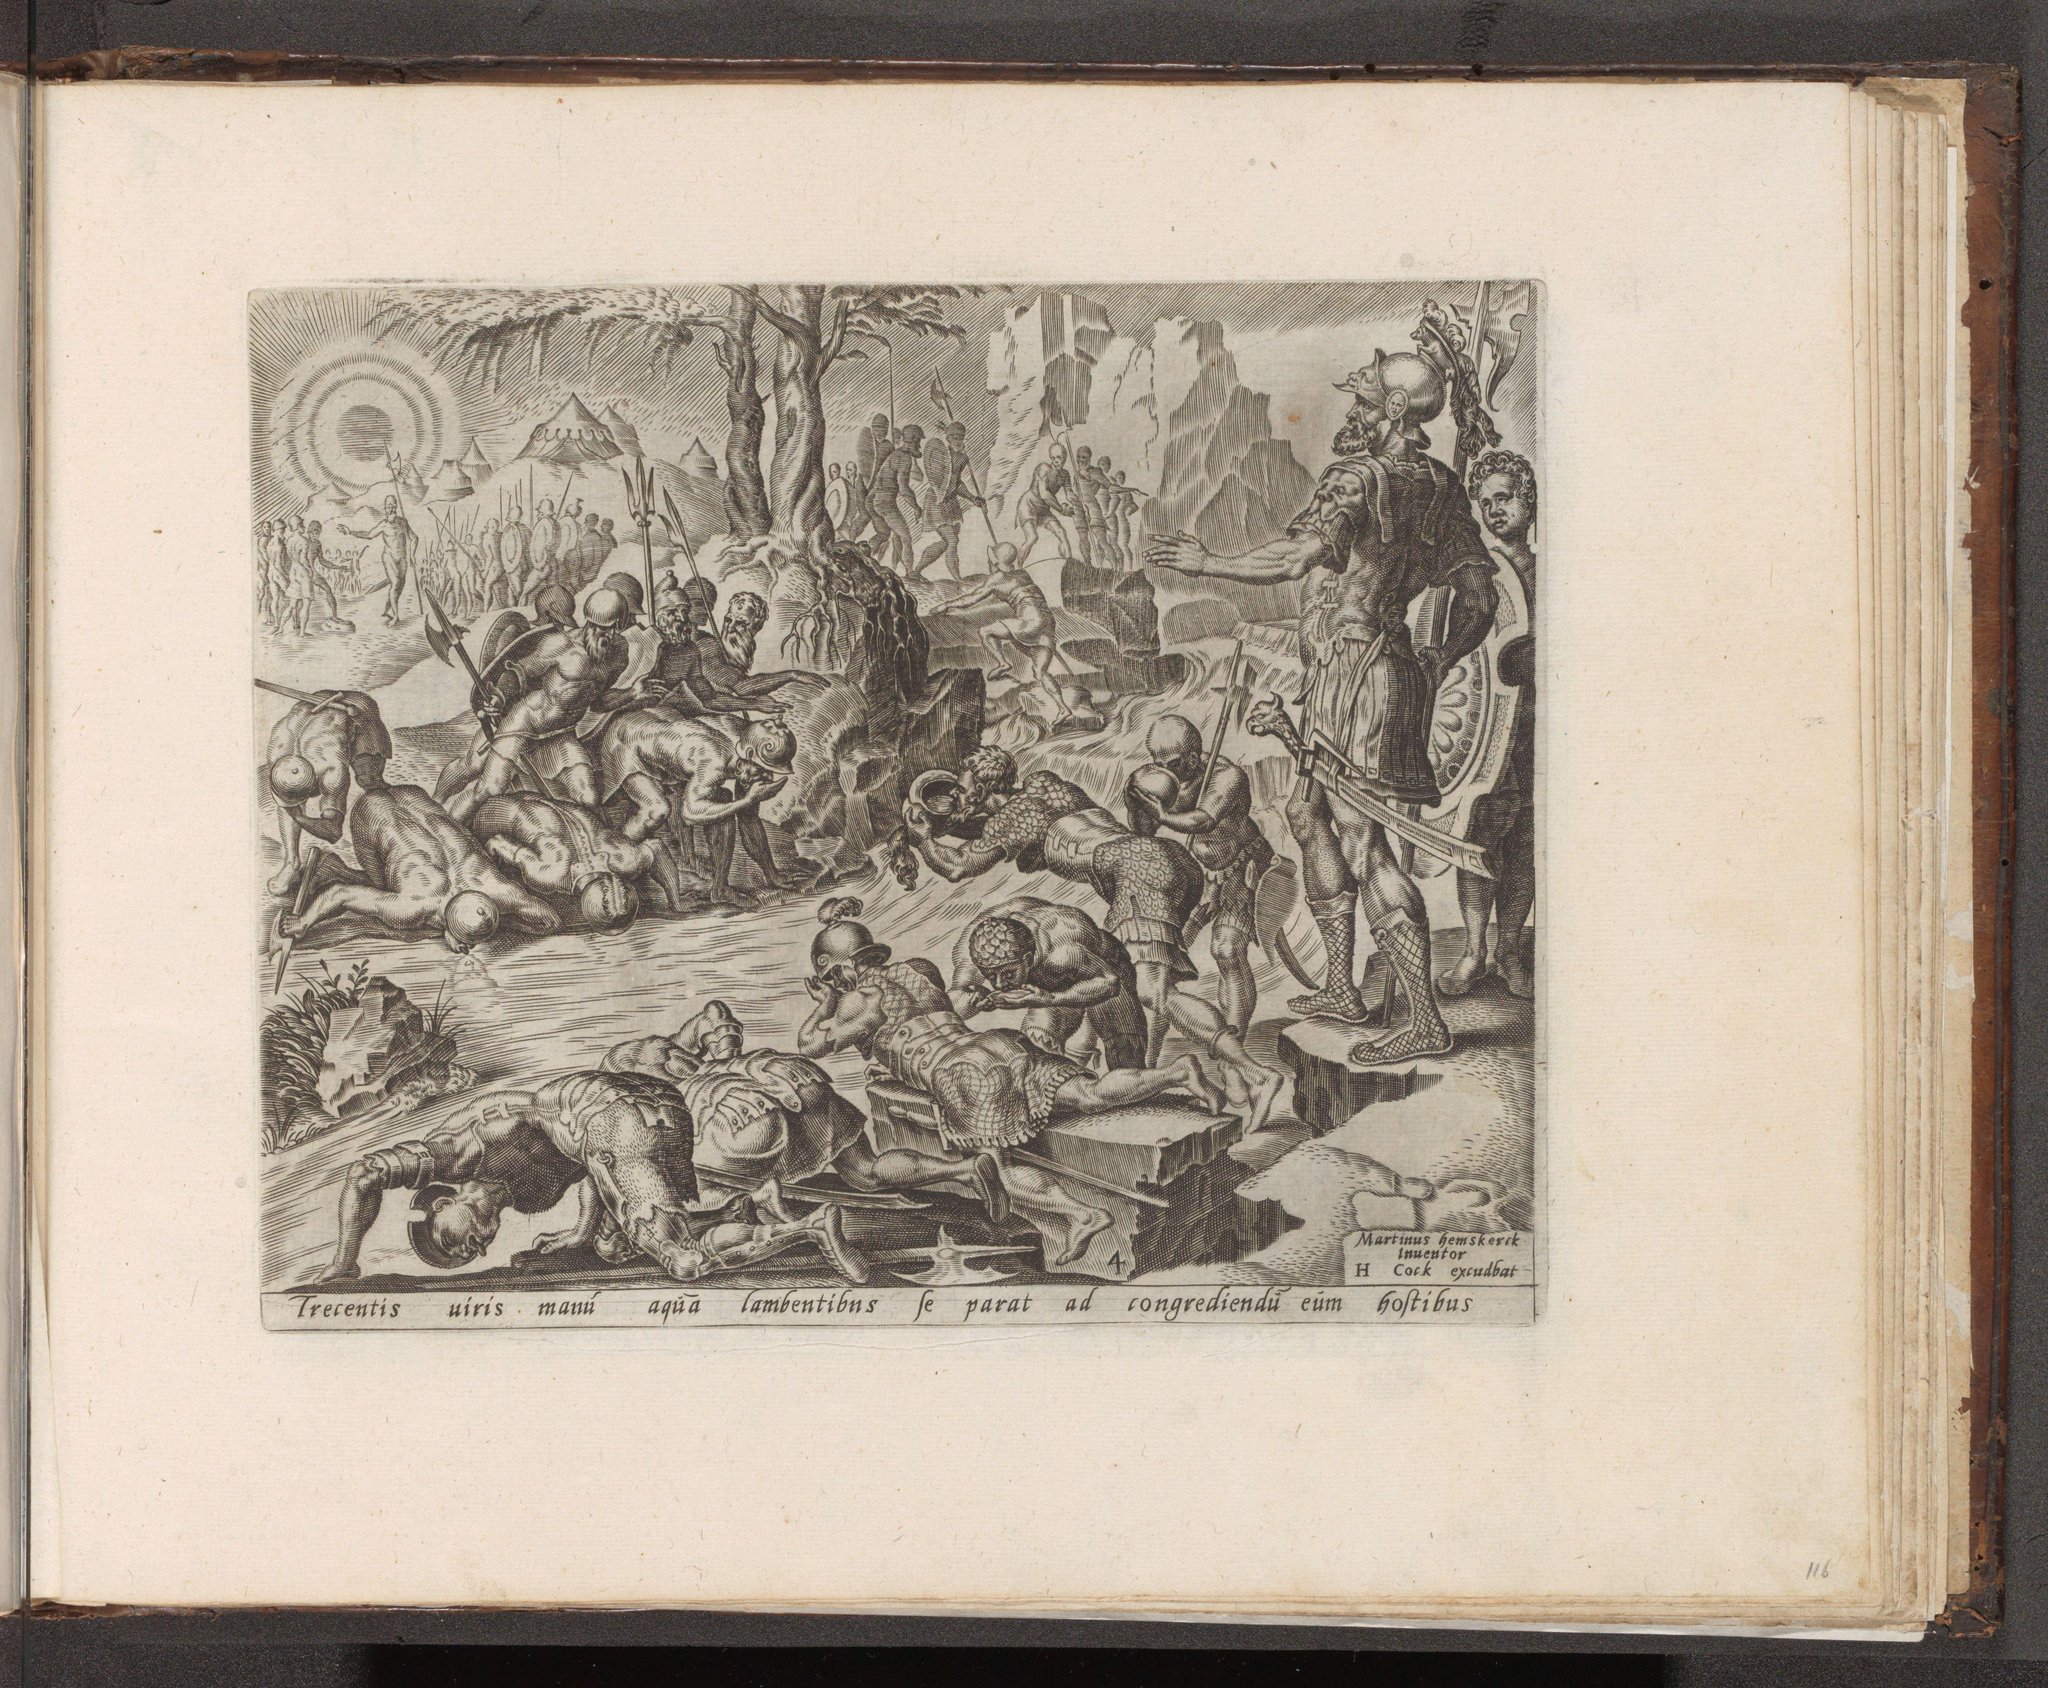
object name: album leaf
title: Gideon selecteert manschappen bij de rivier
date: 1561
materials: paper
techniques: engraving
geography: antwerp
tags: those who lap water by putting their hand to their mouth are separated from those who kneel down to drink the water ~ selection of gideon's men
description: Na een eerste selectie zijn er nog steeds teveel manschappen en raadt God Gideon aan om de overige mannen mee te nemen naar de rivier. Driehonderd man likken het water op met hun tong en de overigen knielen om te drinken. God vertelde Gideon dat Israël met de hulp van de driehonderd man die het water oplikten, Israël zou gaan bevrijden. Onder de voorstelling een onderschrift in het Latijn. Prent maakt deel uit van een album.